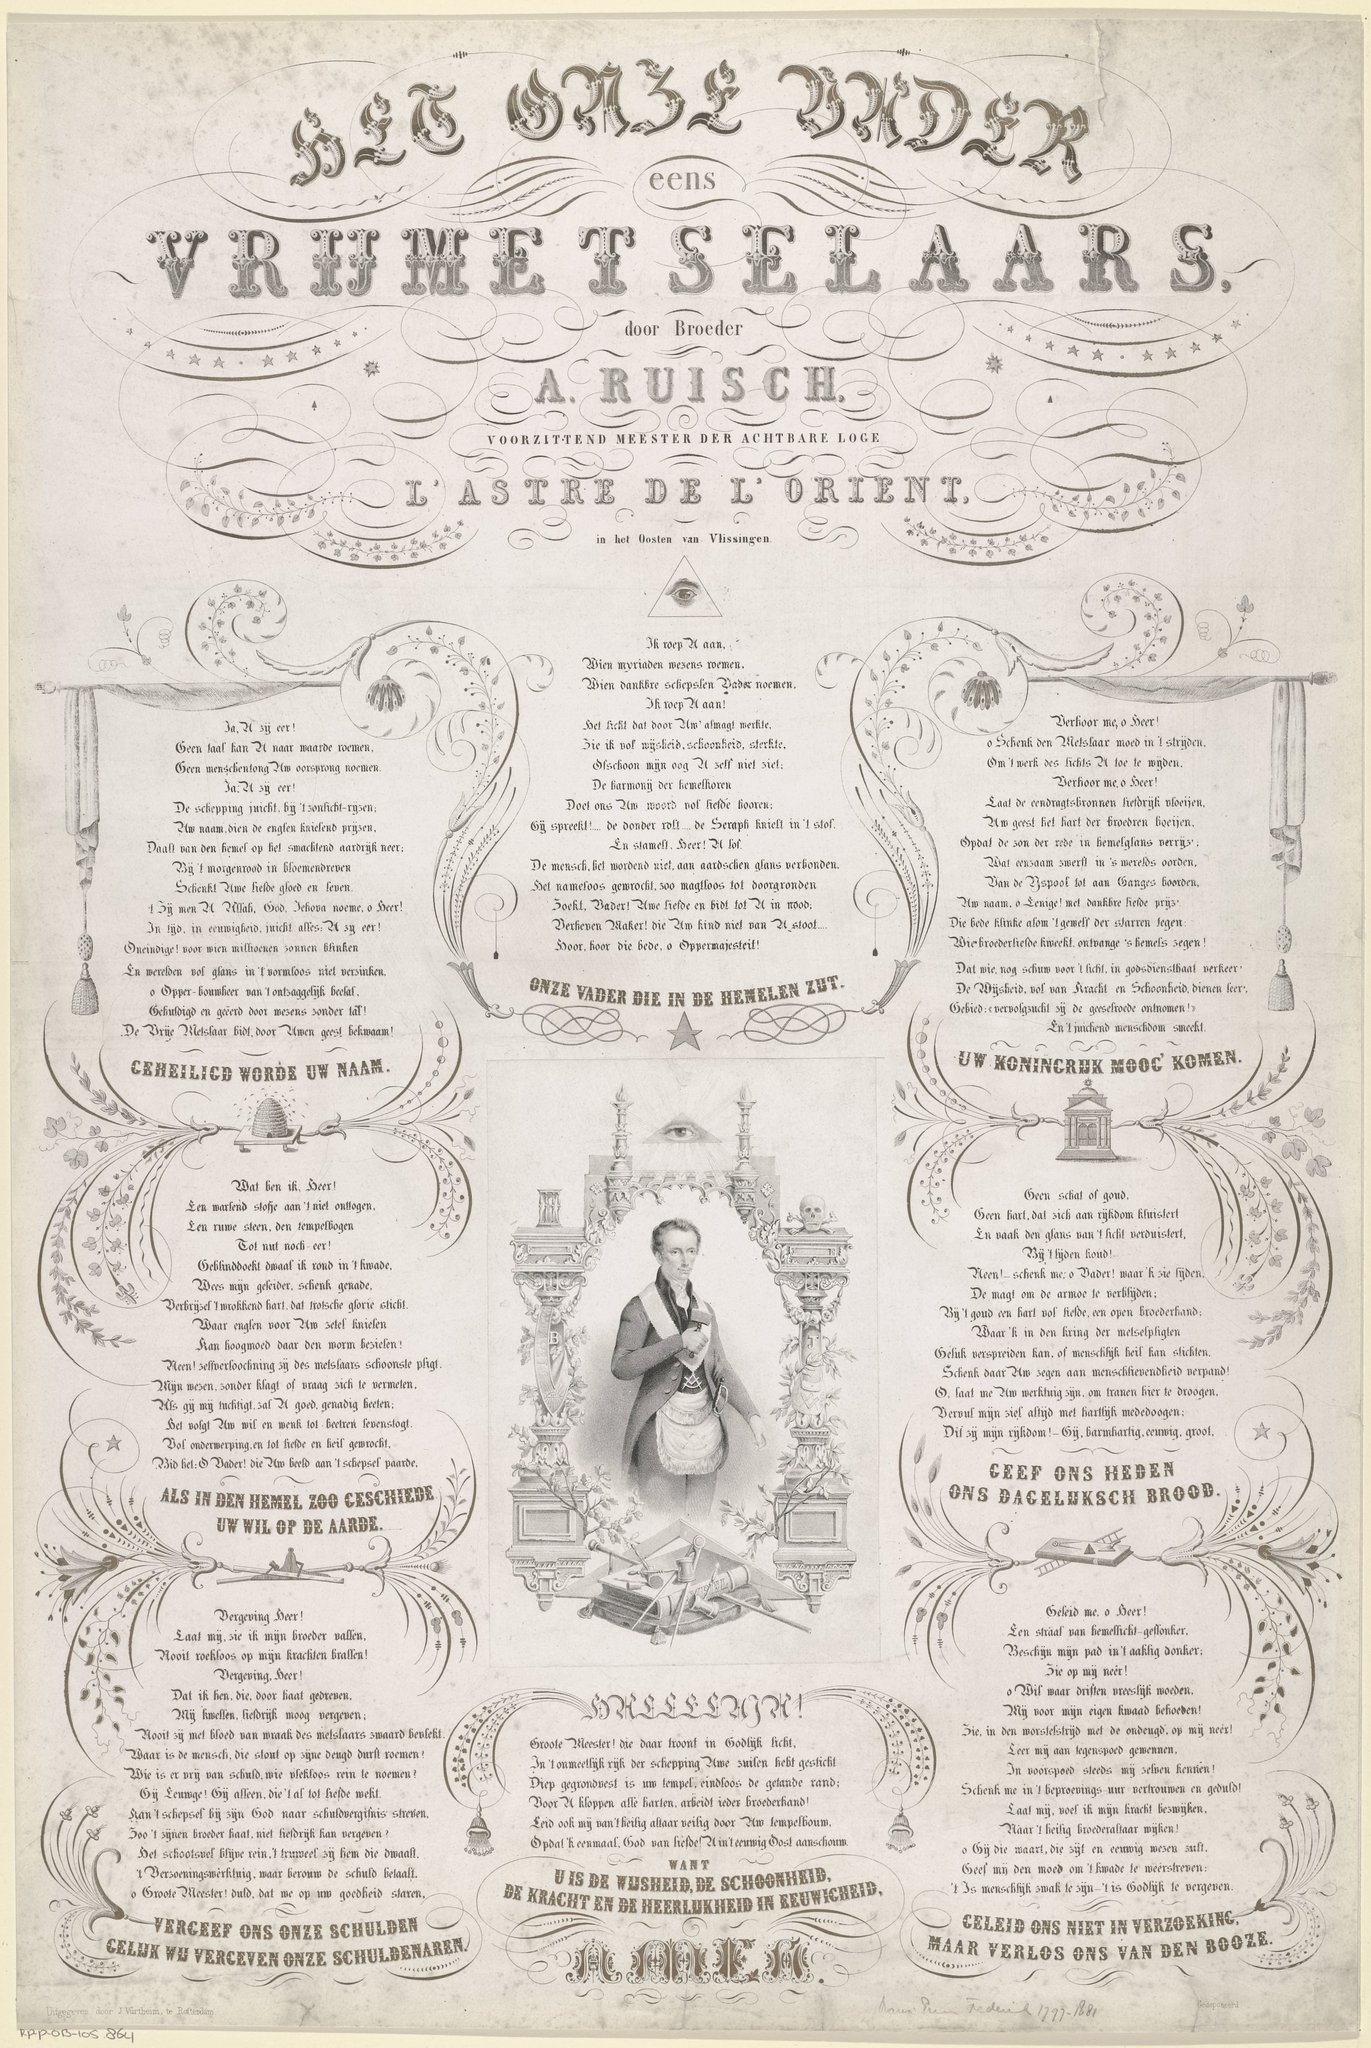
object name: print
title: Het Onze Vader eens Vrijmetselaars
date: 1823-1900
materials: paper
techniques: lithograph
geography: netherlands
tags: frederik (prins der nederlanden), ritual objects and ritual means ~ freemasonry, prince, historical persons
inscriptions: octrooivermelding, gedrukt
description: Portret van Frederik als grootmeester der Vrijmetselaren in een ovaal van allegorische objecten, waaronder een passer en een winkelhaak. In zijn rechterhand een hamer. Daar omheen zeven kolommen met Nederlandse tekst.